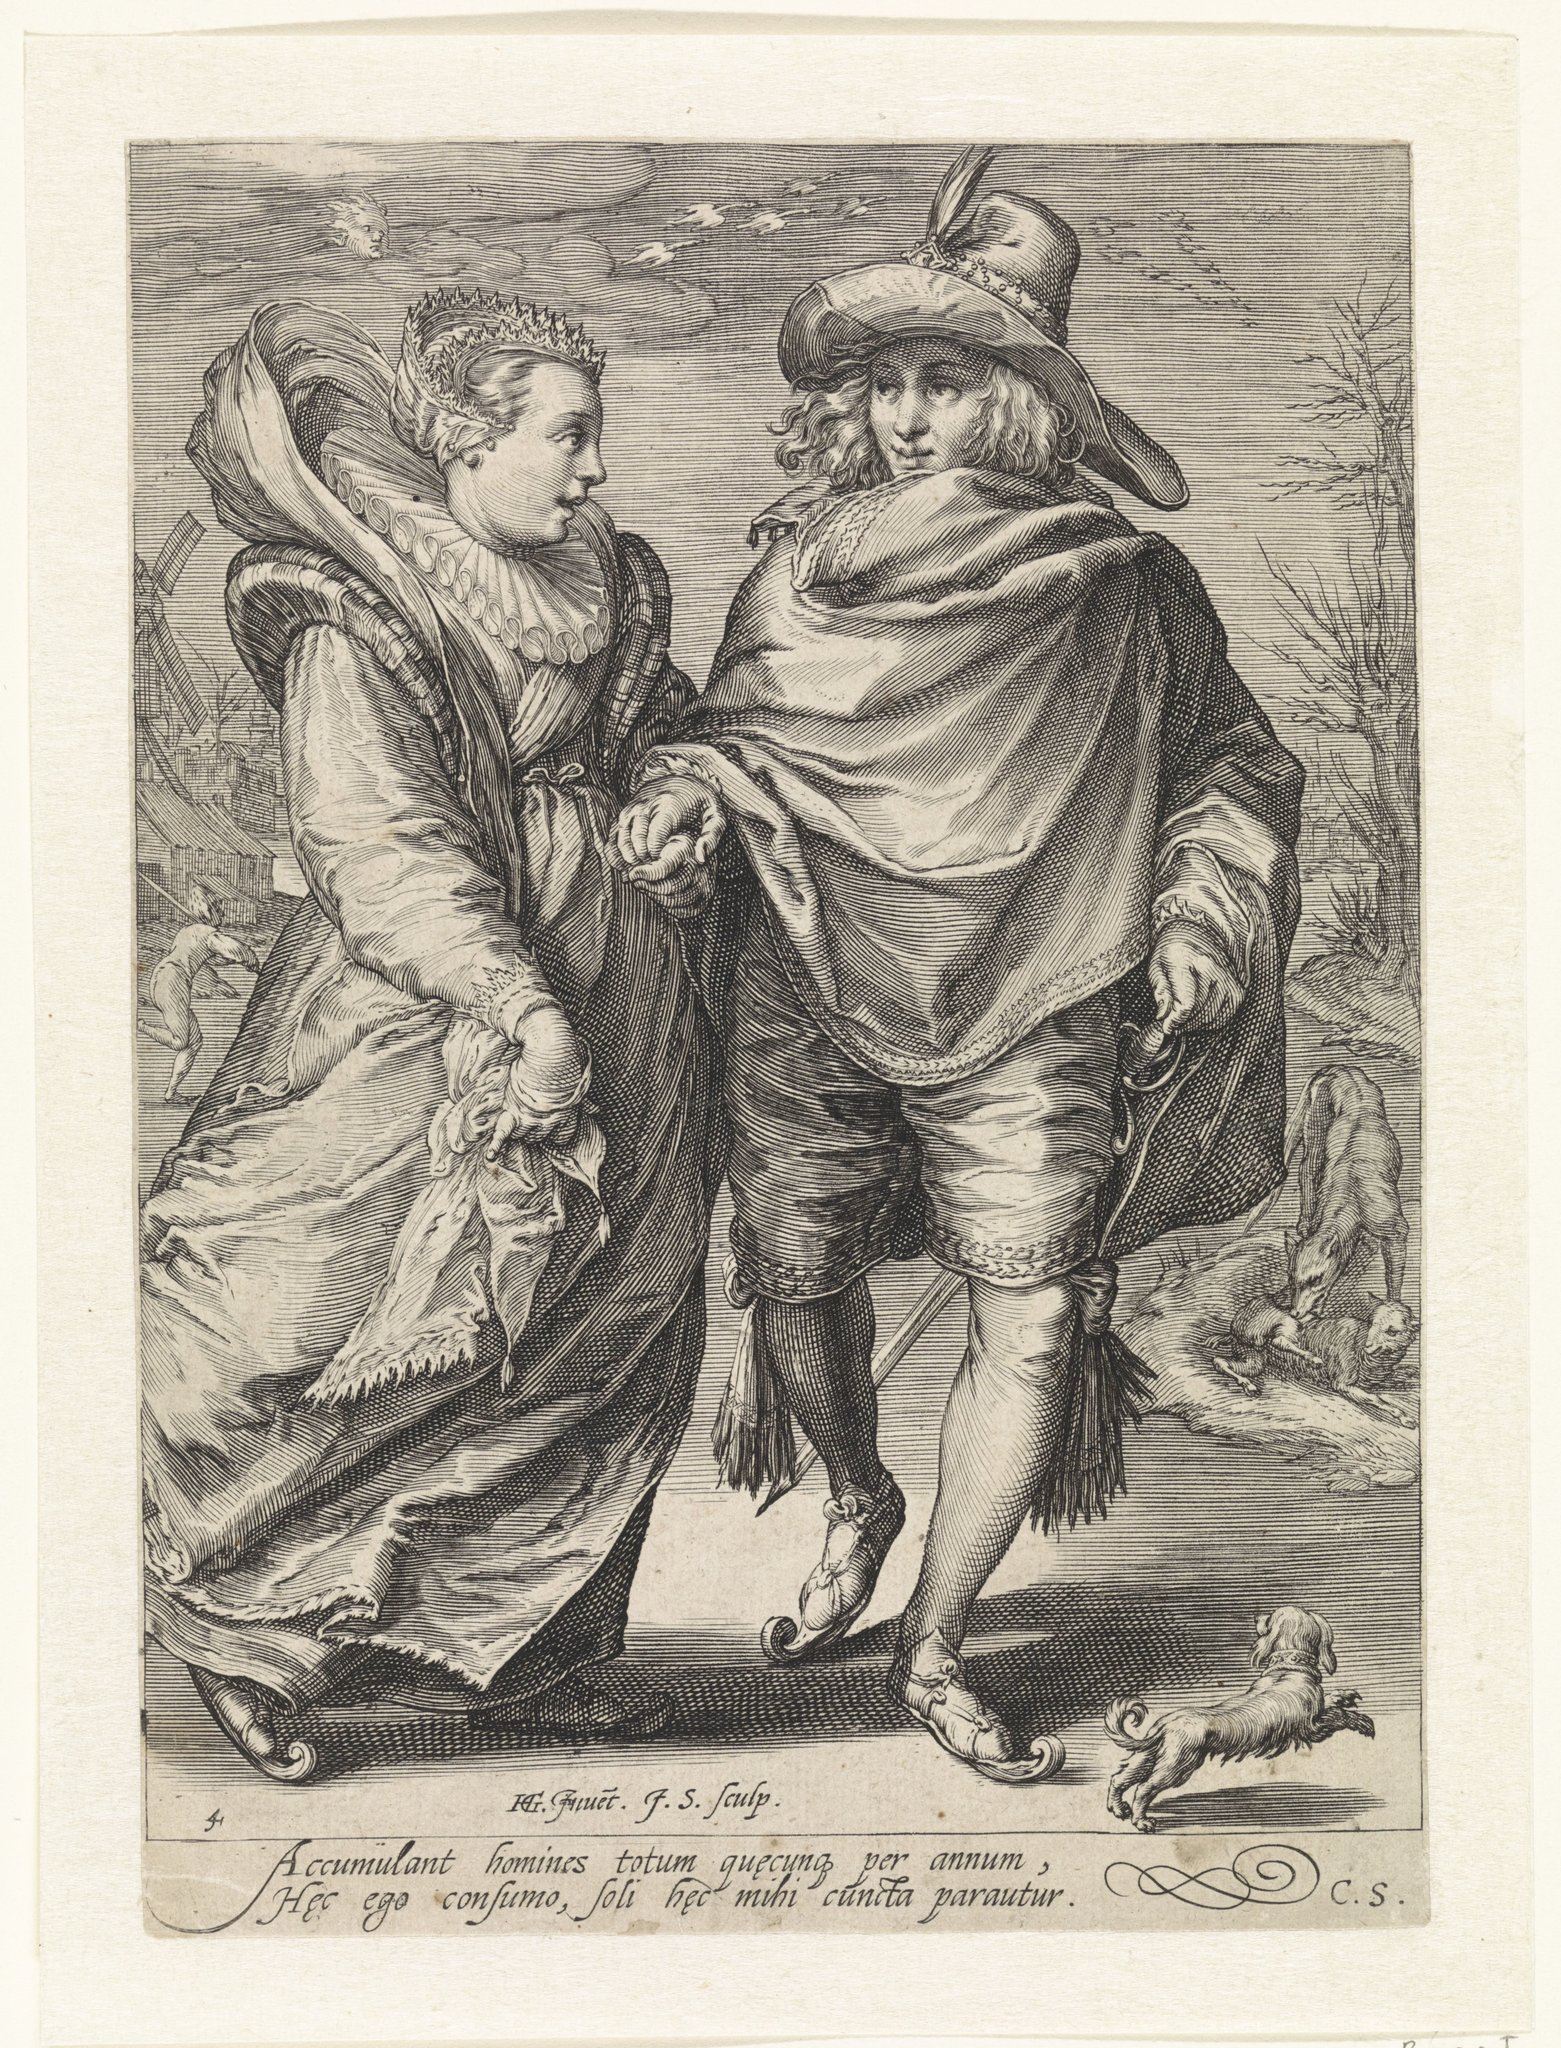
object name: print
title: De Winter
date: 1601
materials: paper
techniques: engraving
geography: northern netherlands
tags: coat (+ women's clothes), cape (+ men's clothes), winter, 'hyems'; 'inverno' (ripa), head-gear: hat (+ men's clothes), clothes, costume (+ women's clothes), neck-gear ~ clothing (with name) (+ women's clothes), clothes, costume (+ men's clothes), skates (winter sports), trousers, breeches, etc. (breeches) (+ men's clothes)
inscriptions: signature: ‘C.S.’ Cornelius Schonaeus, collector's mark: Lugt 2228, number: ‘4’, signature: ‘J.S. sculp.’, caption: ‘Accumulant homines...cuncta parantur’, signature: ‘H.G. Inve[n]t’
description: Een jong koppel schaatst hand in hand op het ijs. De figuren zijn elegant gekleed volgens de mode van ca. 1600. Bij hun voeten loopt een hondje over het ijs.